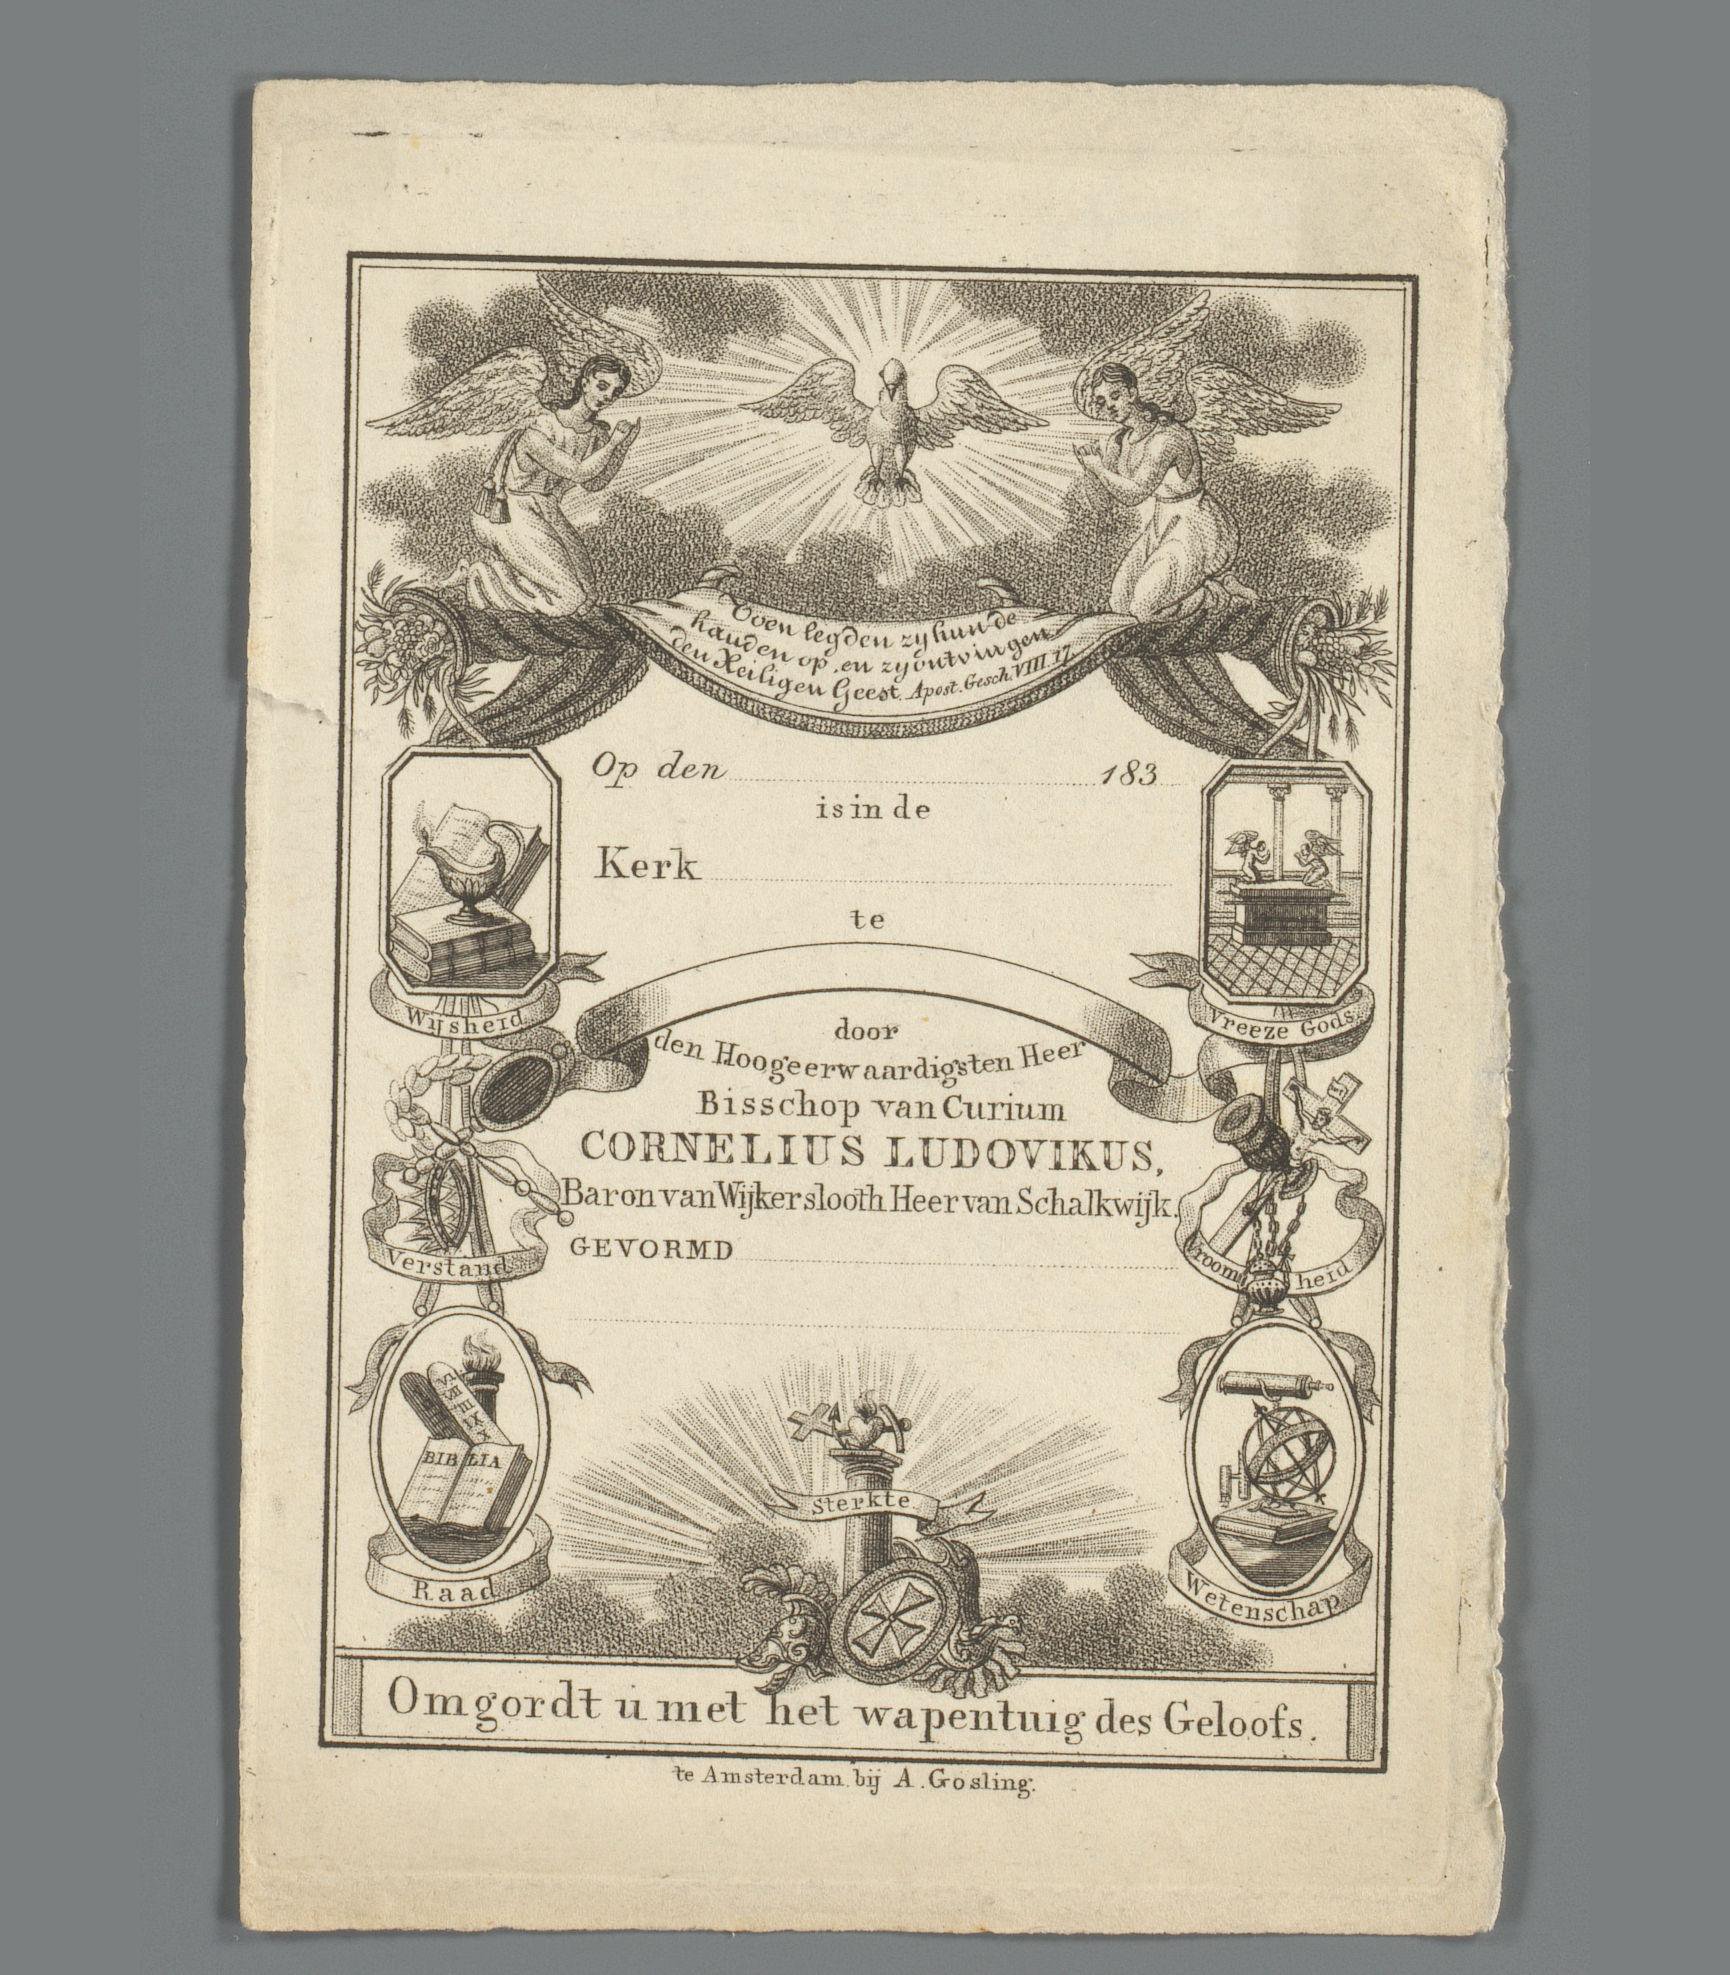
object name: print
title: Kaart voor het ontvangen van het vormsel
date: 1830-1850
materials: paper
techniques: engraving, roulette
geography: amsterdam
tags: haarlem, confirmation ~ the second of the seven sacraments, angels, holy ghost represented as a dove (in flames)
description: Twee engelen aan weerszijden van een duif (de Heilige Geest). Daaronder de oningevulde kaart voor het ontvangen van het vormsel door 'den Hoogeerwaardigsten Heer Bisschop van Curium Cornelius Ludovikus, Baron van Wijkerslooth Heer van Schalkwijk'.